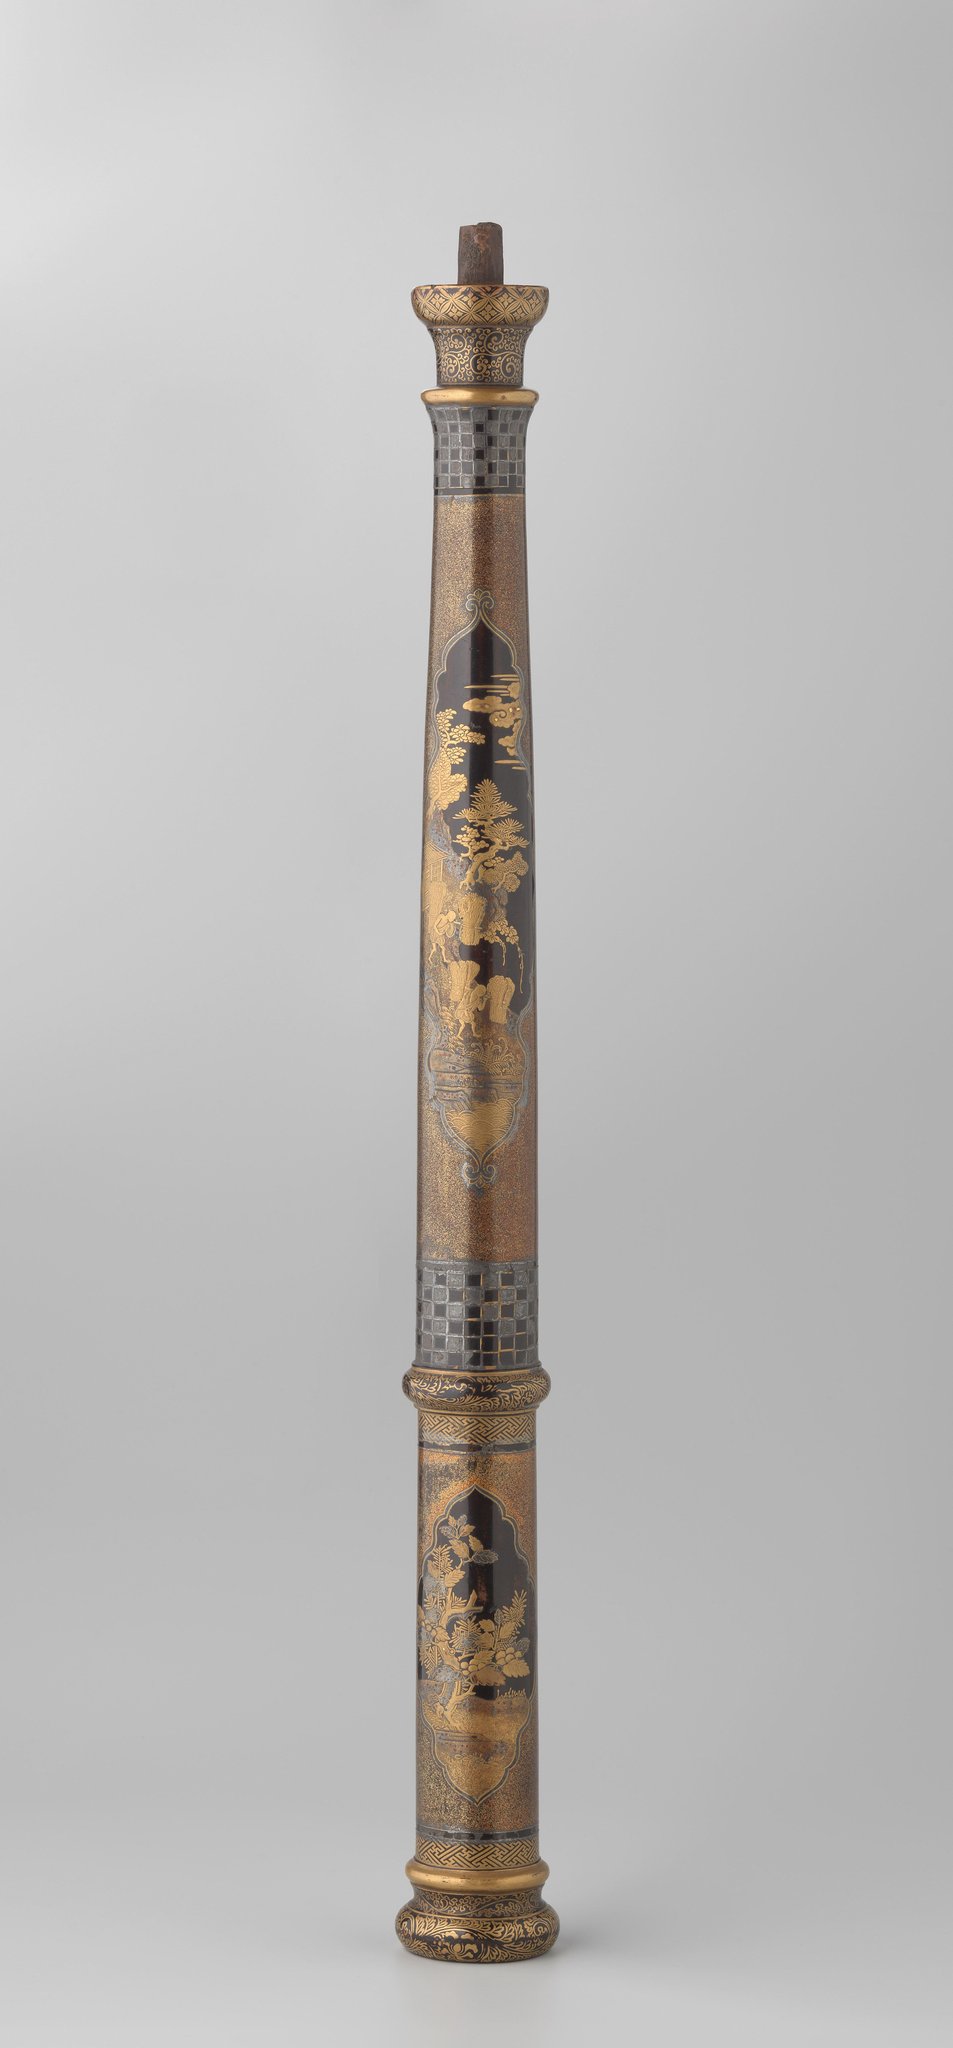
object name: baluster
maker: Anonymous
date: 1635-1640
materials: lacquer, wood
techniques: lacquer, turning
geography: japan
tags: amalia of solms-braunfels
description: This is part of a balustrade, a low fence or barrier. It stood in Huis ten Bosch Palace, the summer residence of Prince Frederick Henry and his wife Amalia of Solms. There it served as a screen for the state bed. In order to obtain the best lacquerwork, the Dutch East India Company (VOC) had to search in Japan for lacquerers who could not only carry out such a large commission, but also work on an object that was completely unknown in Japan.